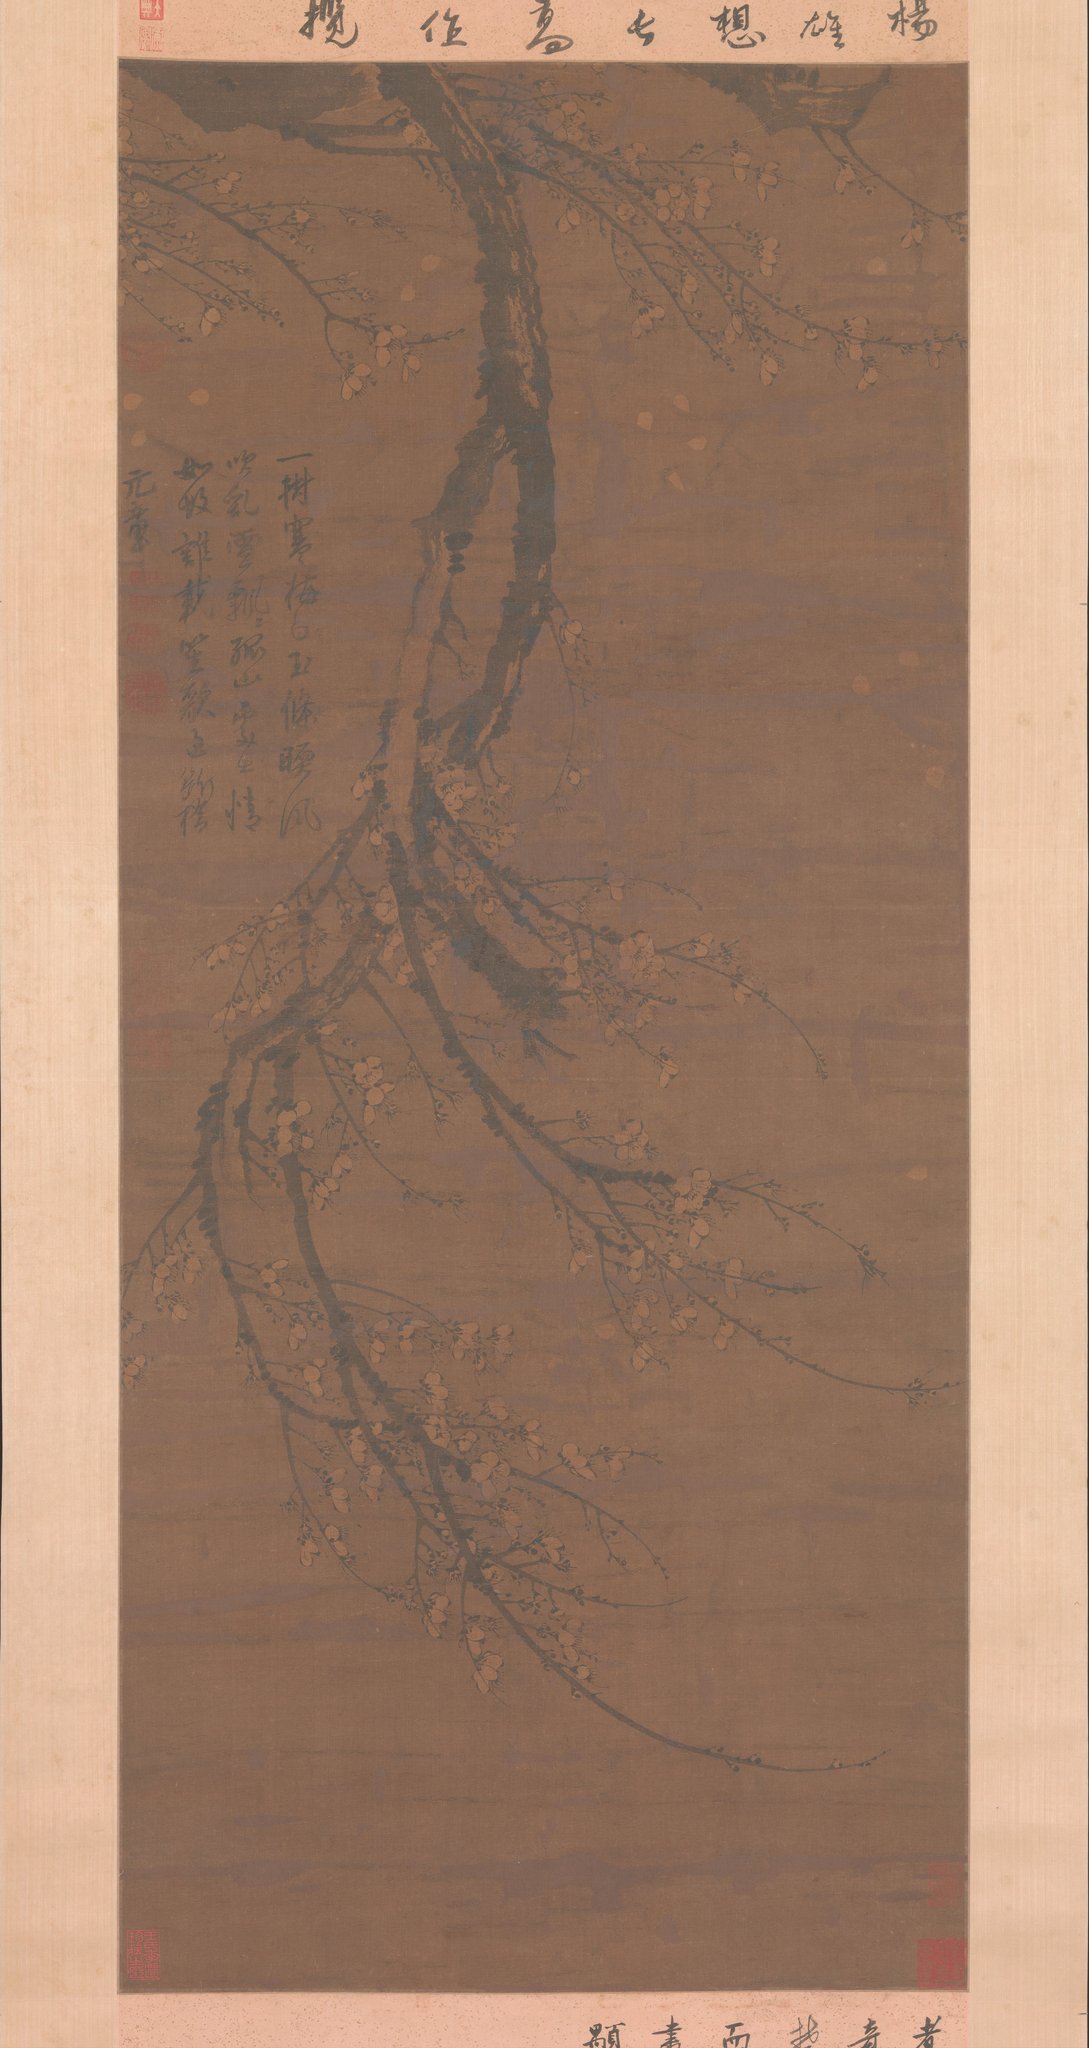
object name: hanging scroll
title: Fragrant Snow at Broken Bridge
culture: chinese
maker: wang mian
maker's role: artist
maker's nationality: chinese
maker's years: 1287-1359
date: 1301-1400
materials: ink, silk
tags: trees